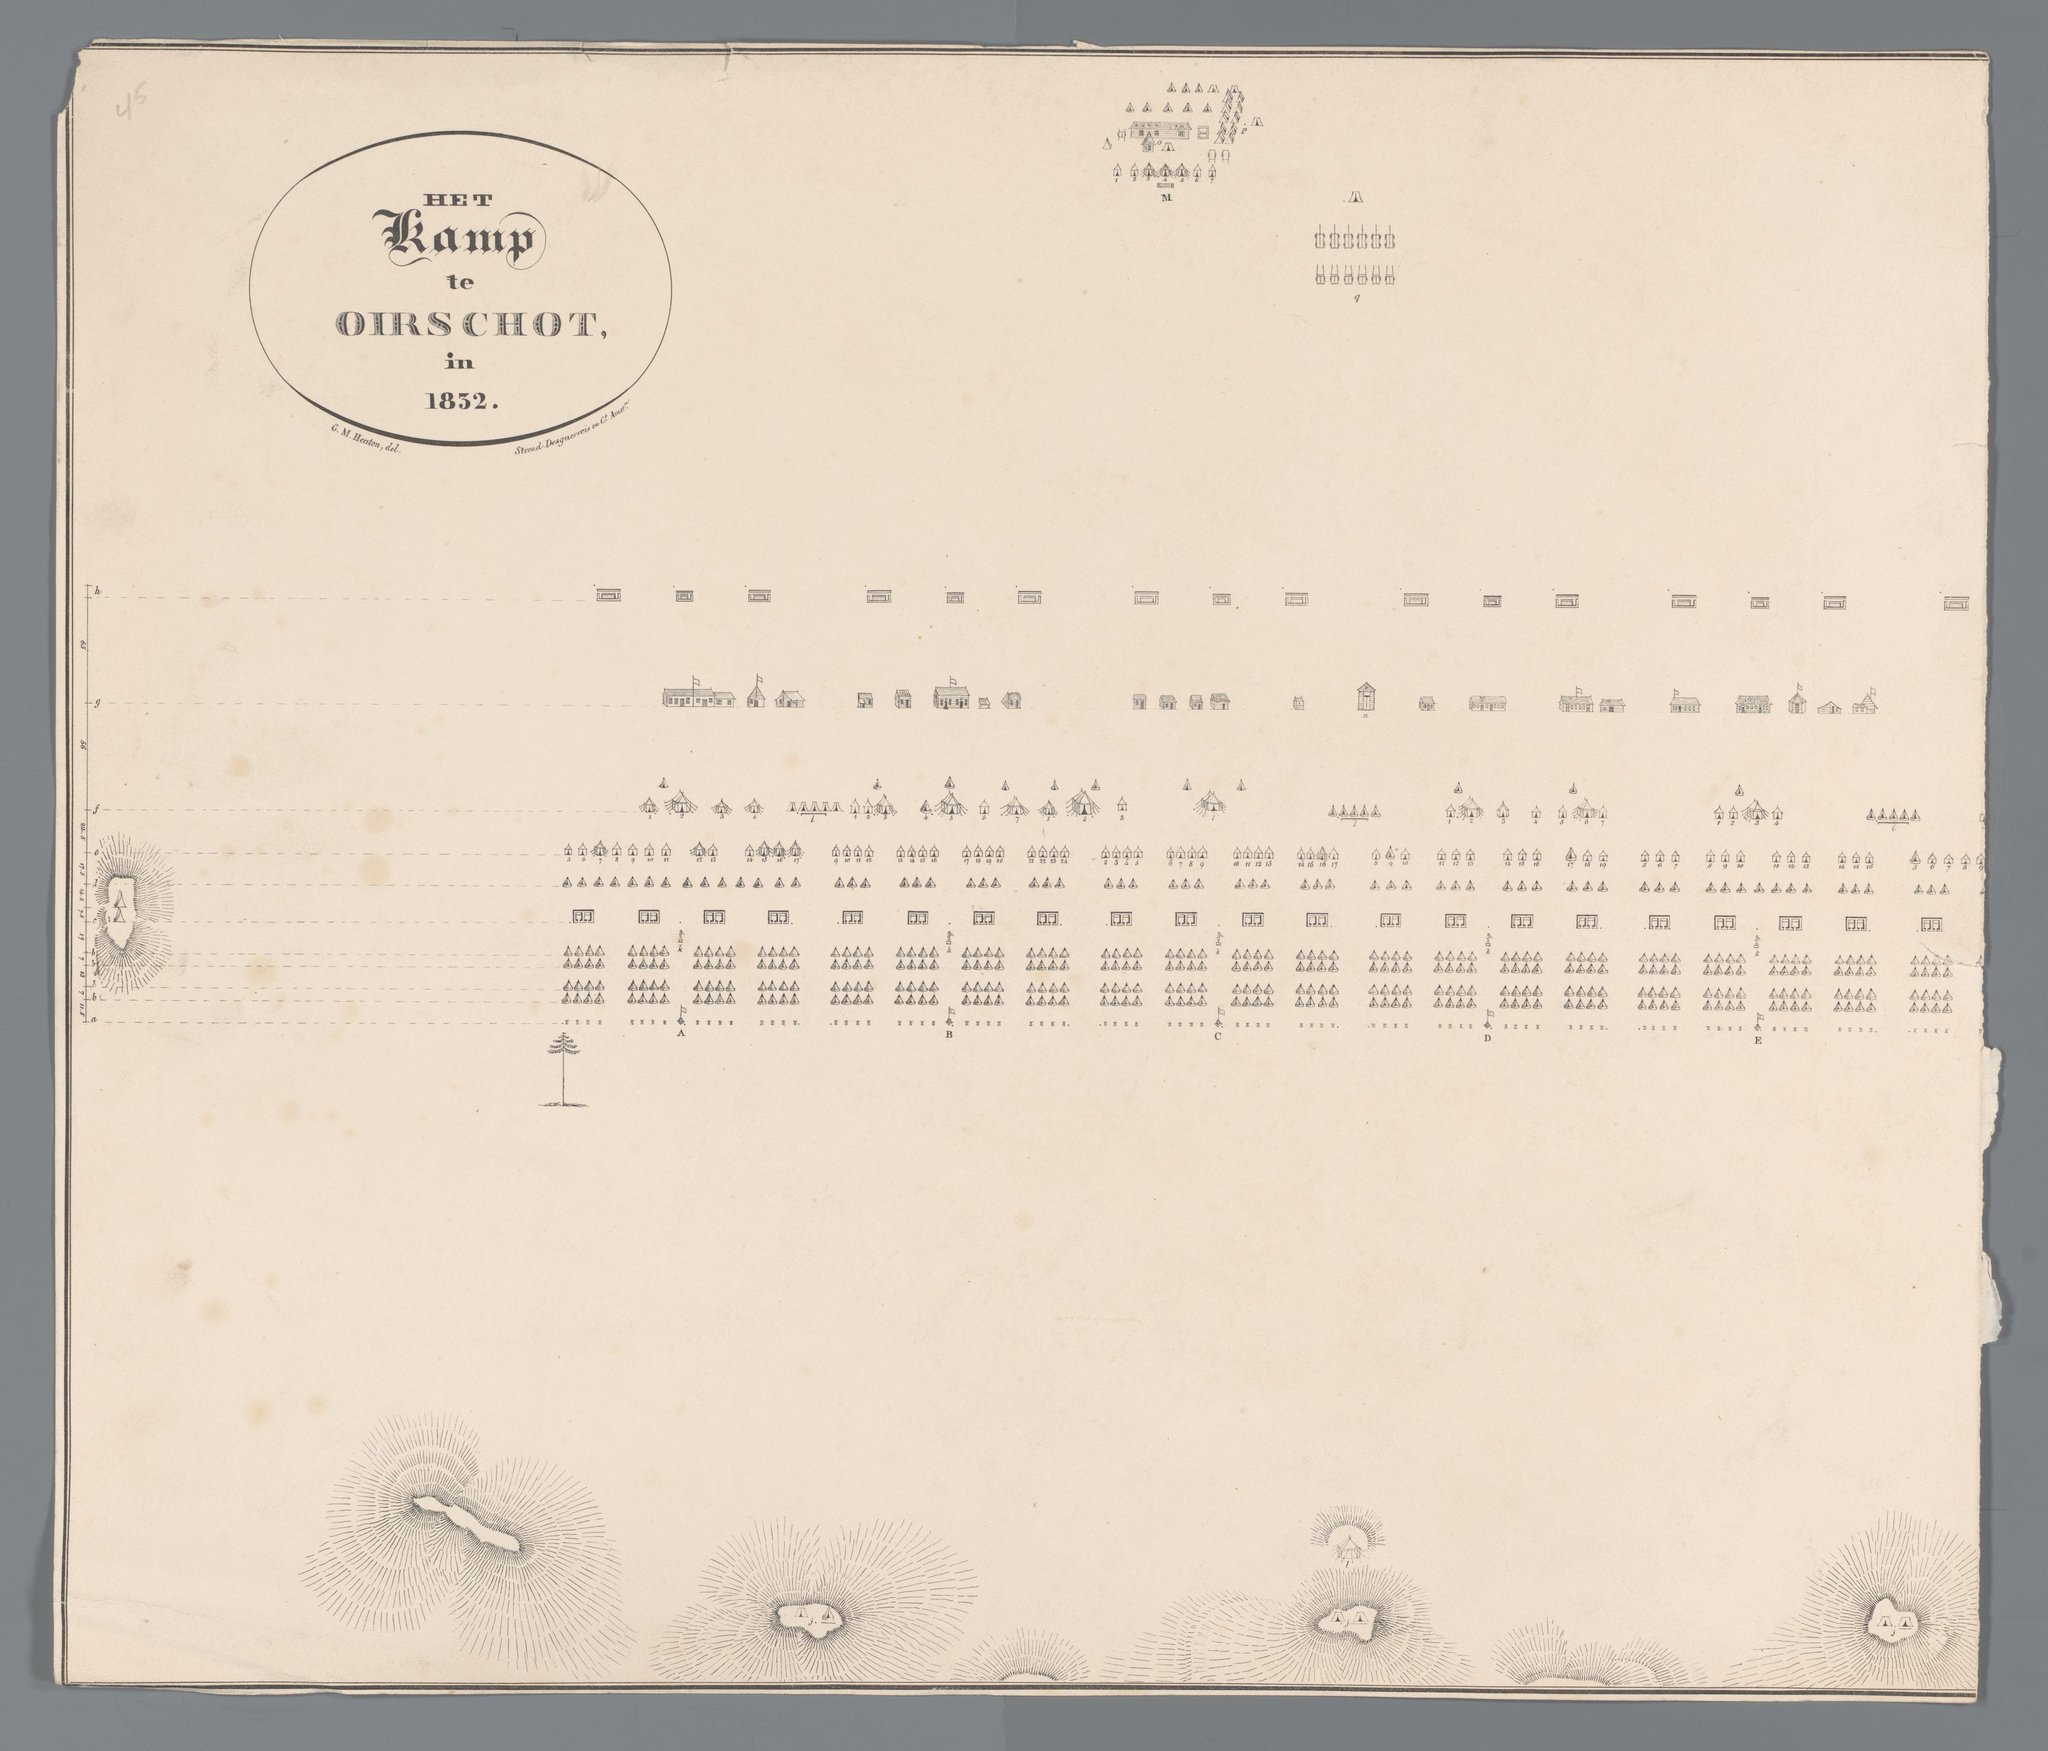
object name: area plan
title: Het Kamp te Oirschot in 1832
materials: paper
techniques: lithograph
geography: amsterdam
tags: (military) camp with tents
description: Plattegrond van het Nederlandse legerkamp in Oirschot, tenten in opstand. Linkerdeel van een voorstelling gedrukt van 2 of 3 stenen (een tussenliggende deel ontbreekt).